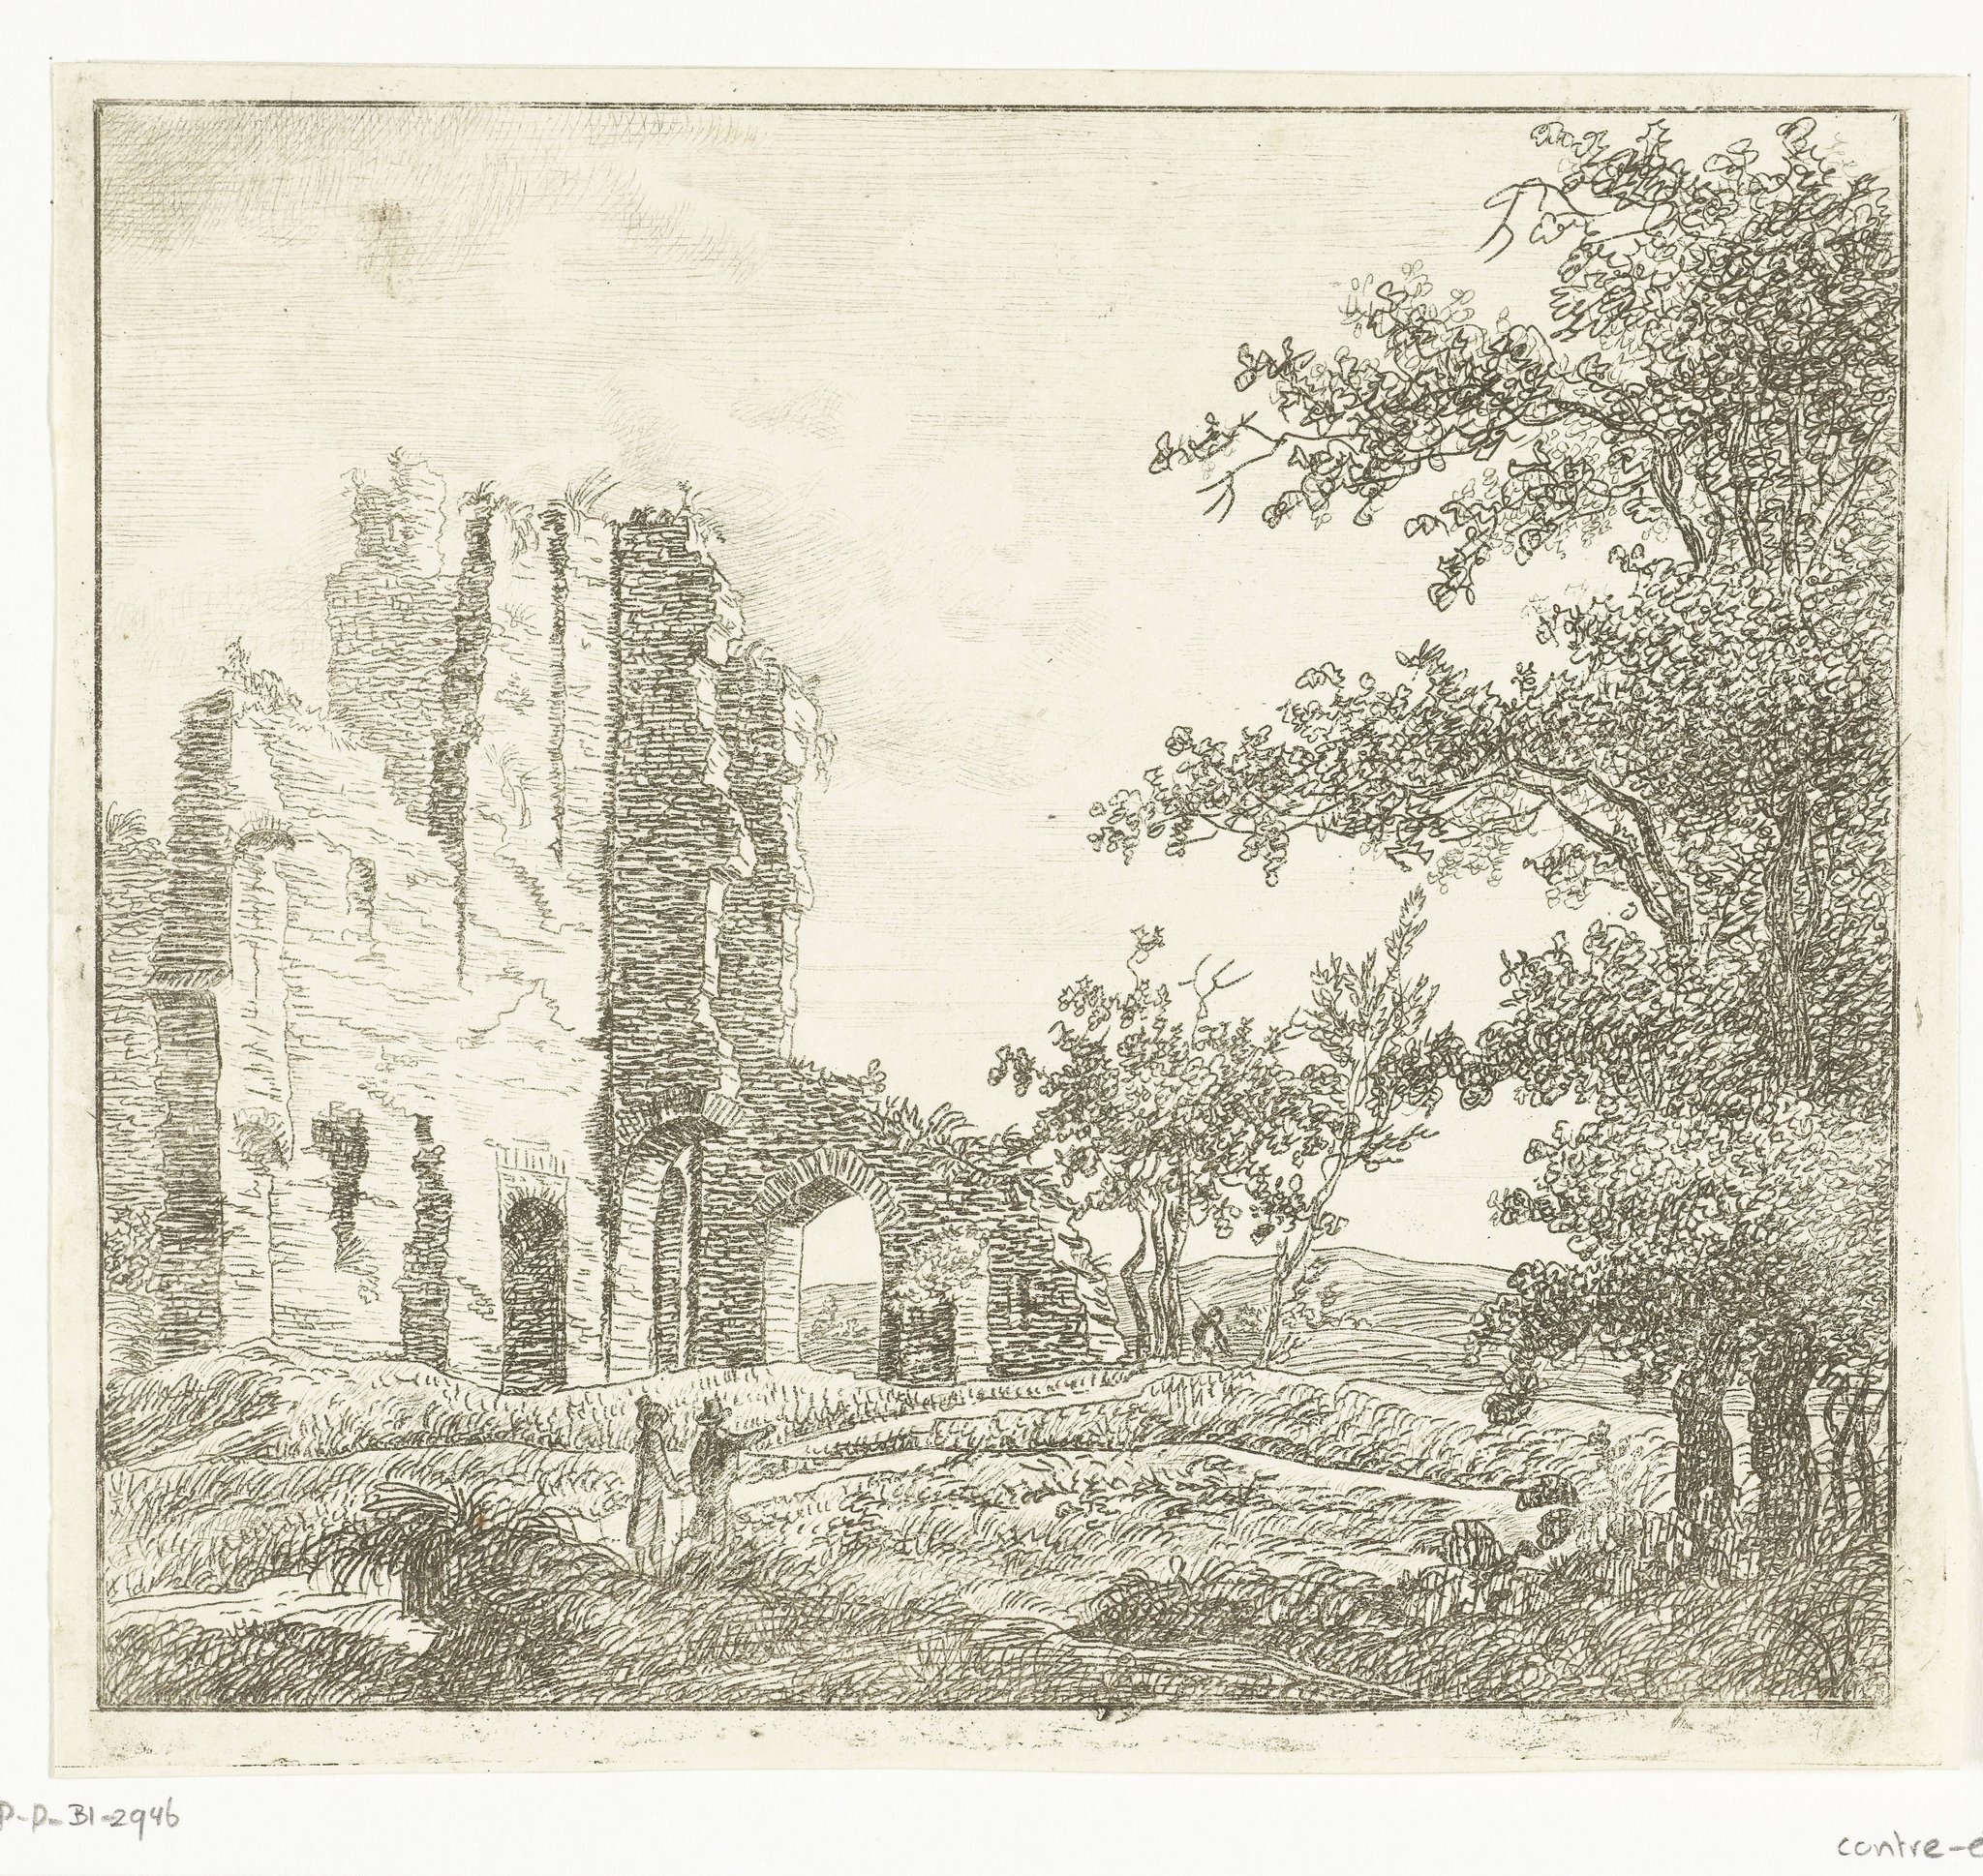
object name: print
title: Ruïne van Brederode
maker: anthonie van den bos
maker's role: draughtsman, print maker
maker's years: 1763-1838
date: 1778-1838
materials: paper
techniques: printmaking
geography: netherlands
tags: ruin of a dwelling, house, castle, etc.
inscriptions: collector's mark: Lugt 2228